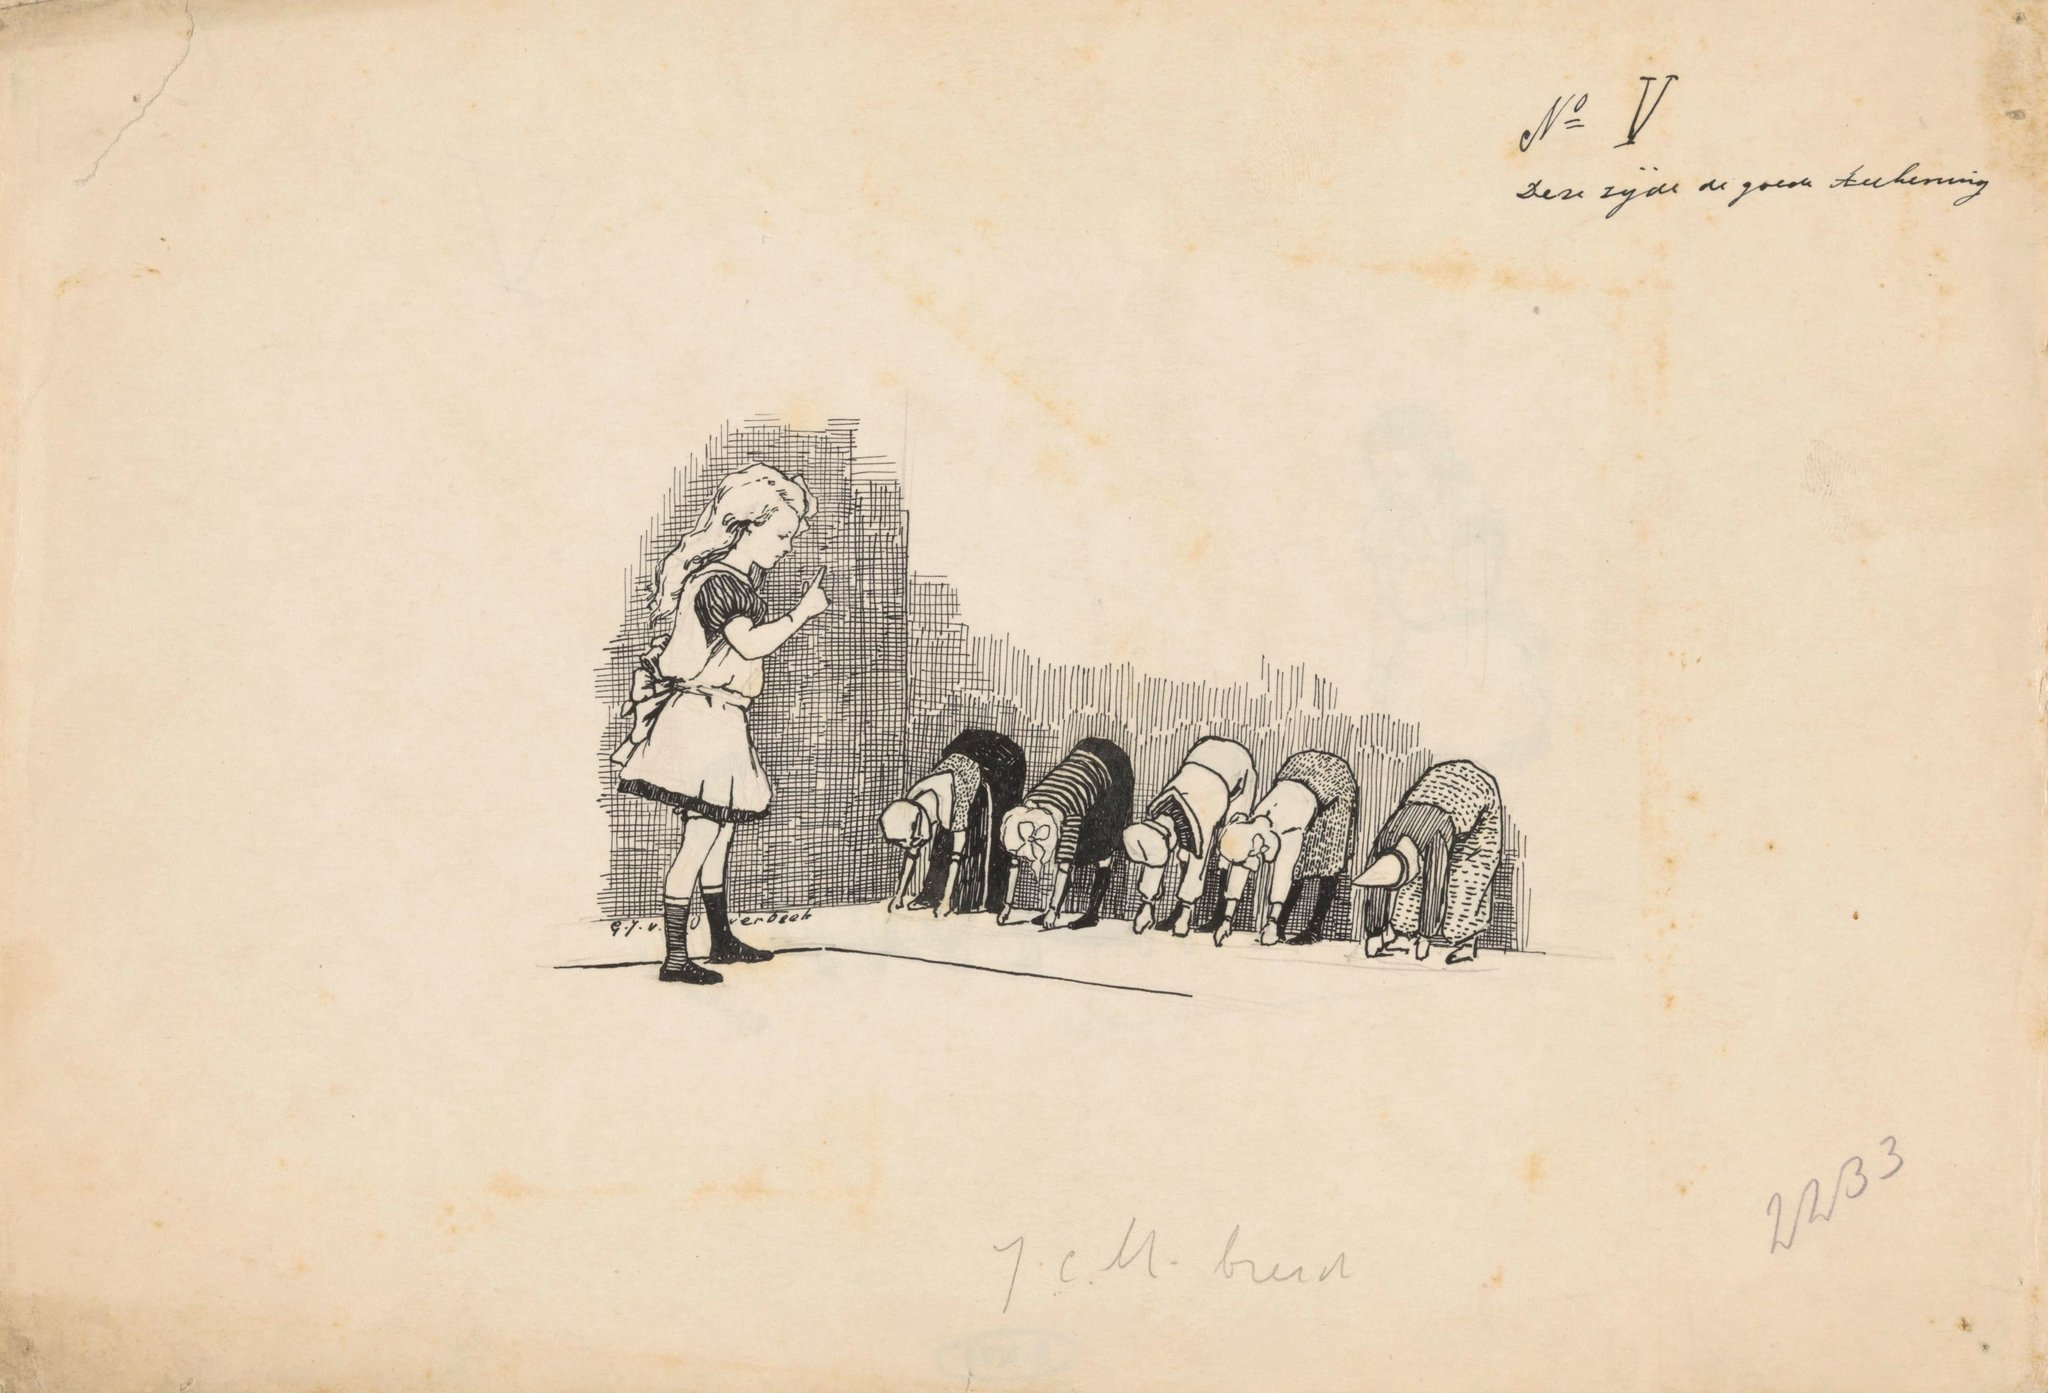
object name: boekillustratie ontwerp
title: Meisje straft haar poppen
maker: gijsbertus johannes van overbeek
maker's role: draughtsman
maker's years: 1882-1947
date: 1892-1947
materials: ink, paper, pencil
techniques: pen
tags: (playing with) dolls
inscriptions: signature: ‘G.J. v. O verbeek’, annotation: ‘No. V/ Deze zijde goede teekening’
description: Een meisje heft haar rechter wijsvinger op naar haar vijf poppen, die zij op een rij tegen de muur heeft opgesteld met de handen en het hoofd naar beneden.